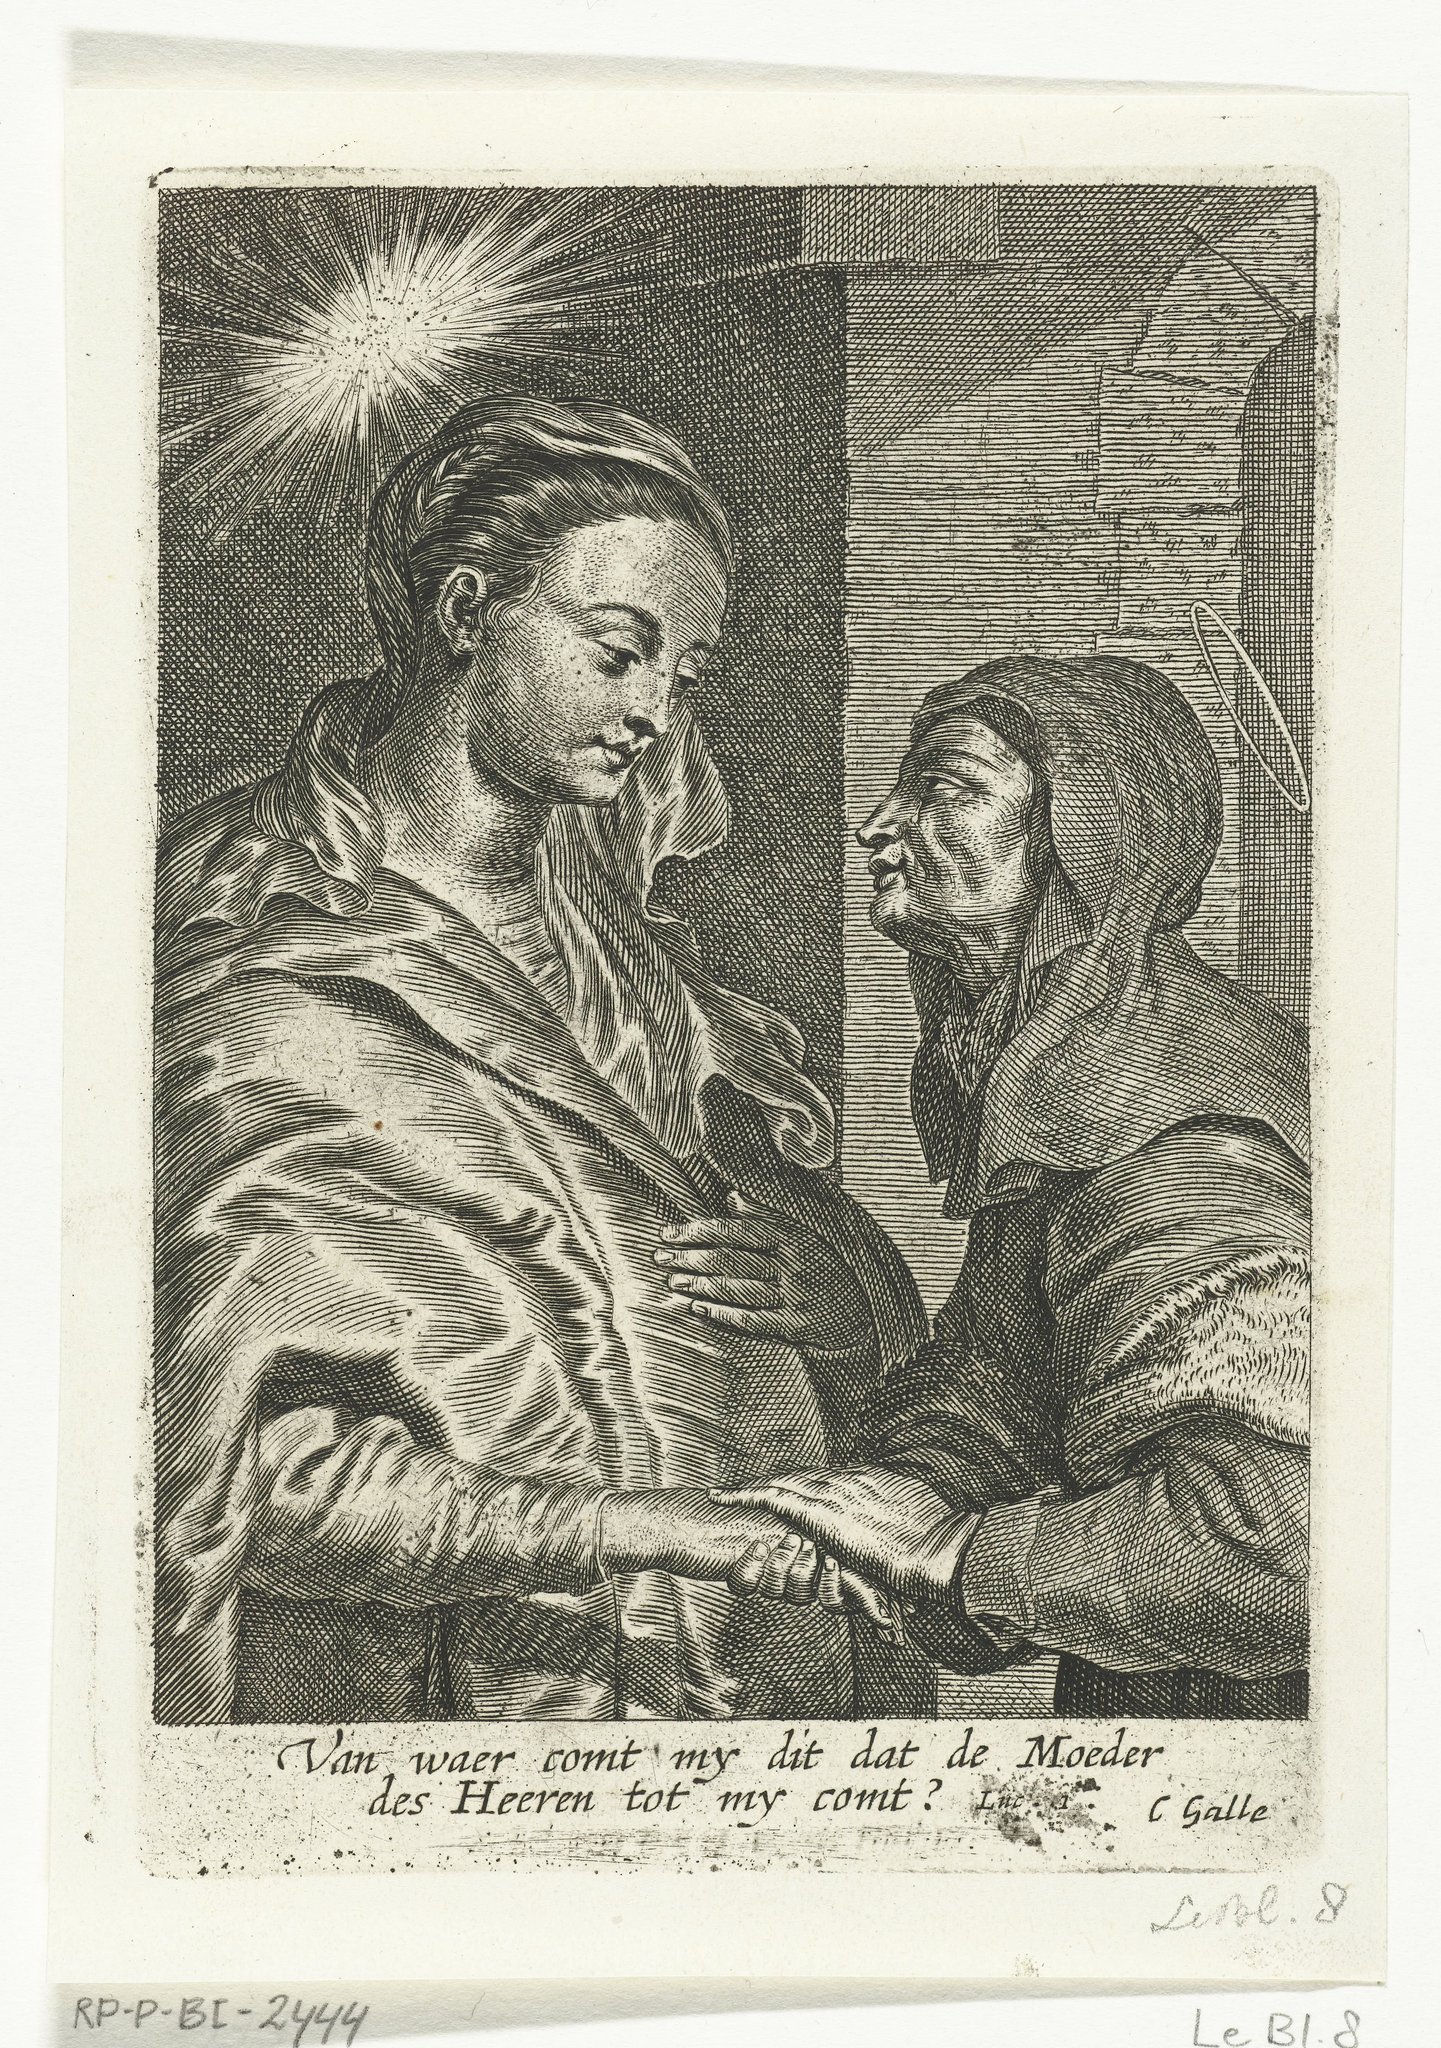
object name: print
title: Visitatie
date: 1596-1678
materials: paper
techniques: engraving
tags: mary and elisabeth shaking hands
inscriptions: collector's mark: Lugt 2228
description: Prent uit serie Vélins met negentig prenten naar ontwerp van Peter Paul Rubens. In de bronnen vinden we uiteenlopende gegevens over aantal en samenstelling van de serie. Hollstein hanteert het aantal van negentig prenten. De reeks Vélins in de collectie van het RMA bevat verschillende staten afkomstig uit meerdere uitgaven welke moeilijk te duiden zijn. Sommige dragen het originele adres van Schelte Adamsz. Bolswert als graveur en uitgever, op andere exemplaren is deze naam verwijderd (duidelijk zichtbaar!) en vervangen door de naam Cornelis Galle (II). De prenten met de naam van uitgever Galle zijn vaak opgewerkt. Uit adressen op de prenten blijkt dat tevens Martien van den Enden de serie uitgaf. Herkomst uit meerdere uitgaven spreekt ook uit afwijkende opschriften in Nederlands en Latijn en variaties op dezelfde thema's welke misschien nooit langs elkaar in dezelfde serie gebruikt werden.